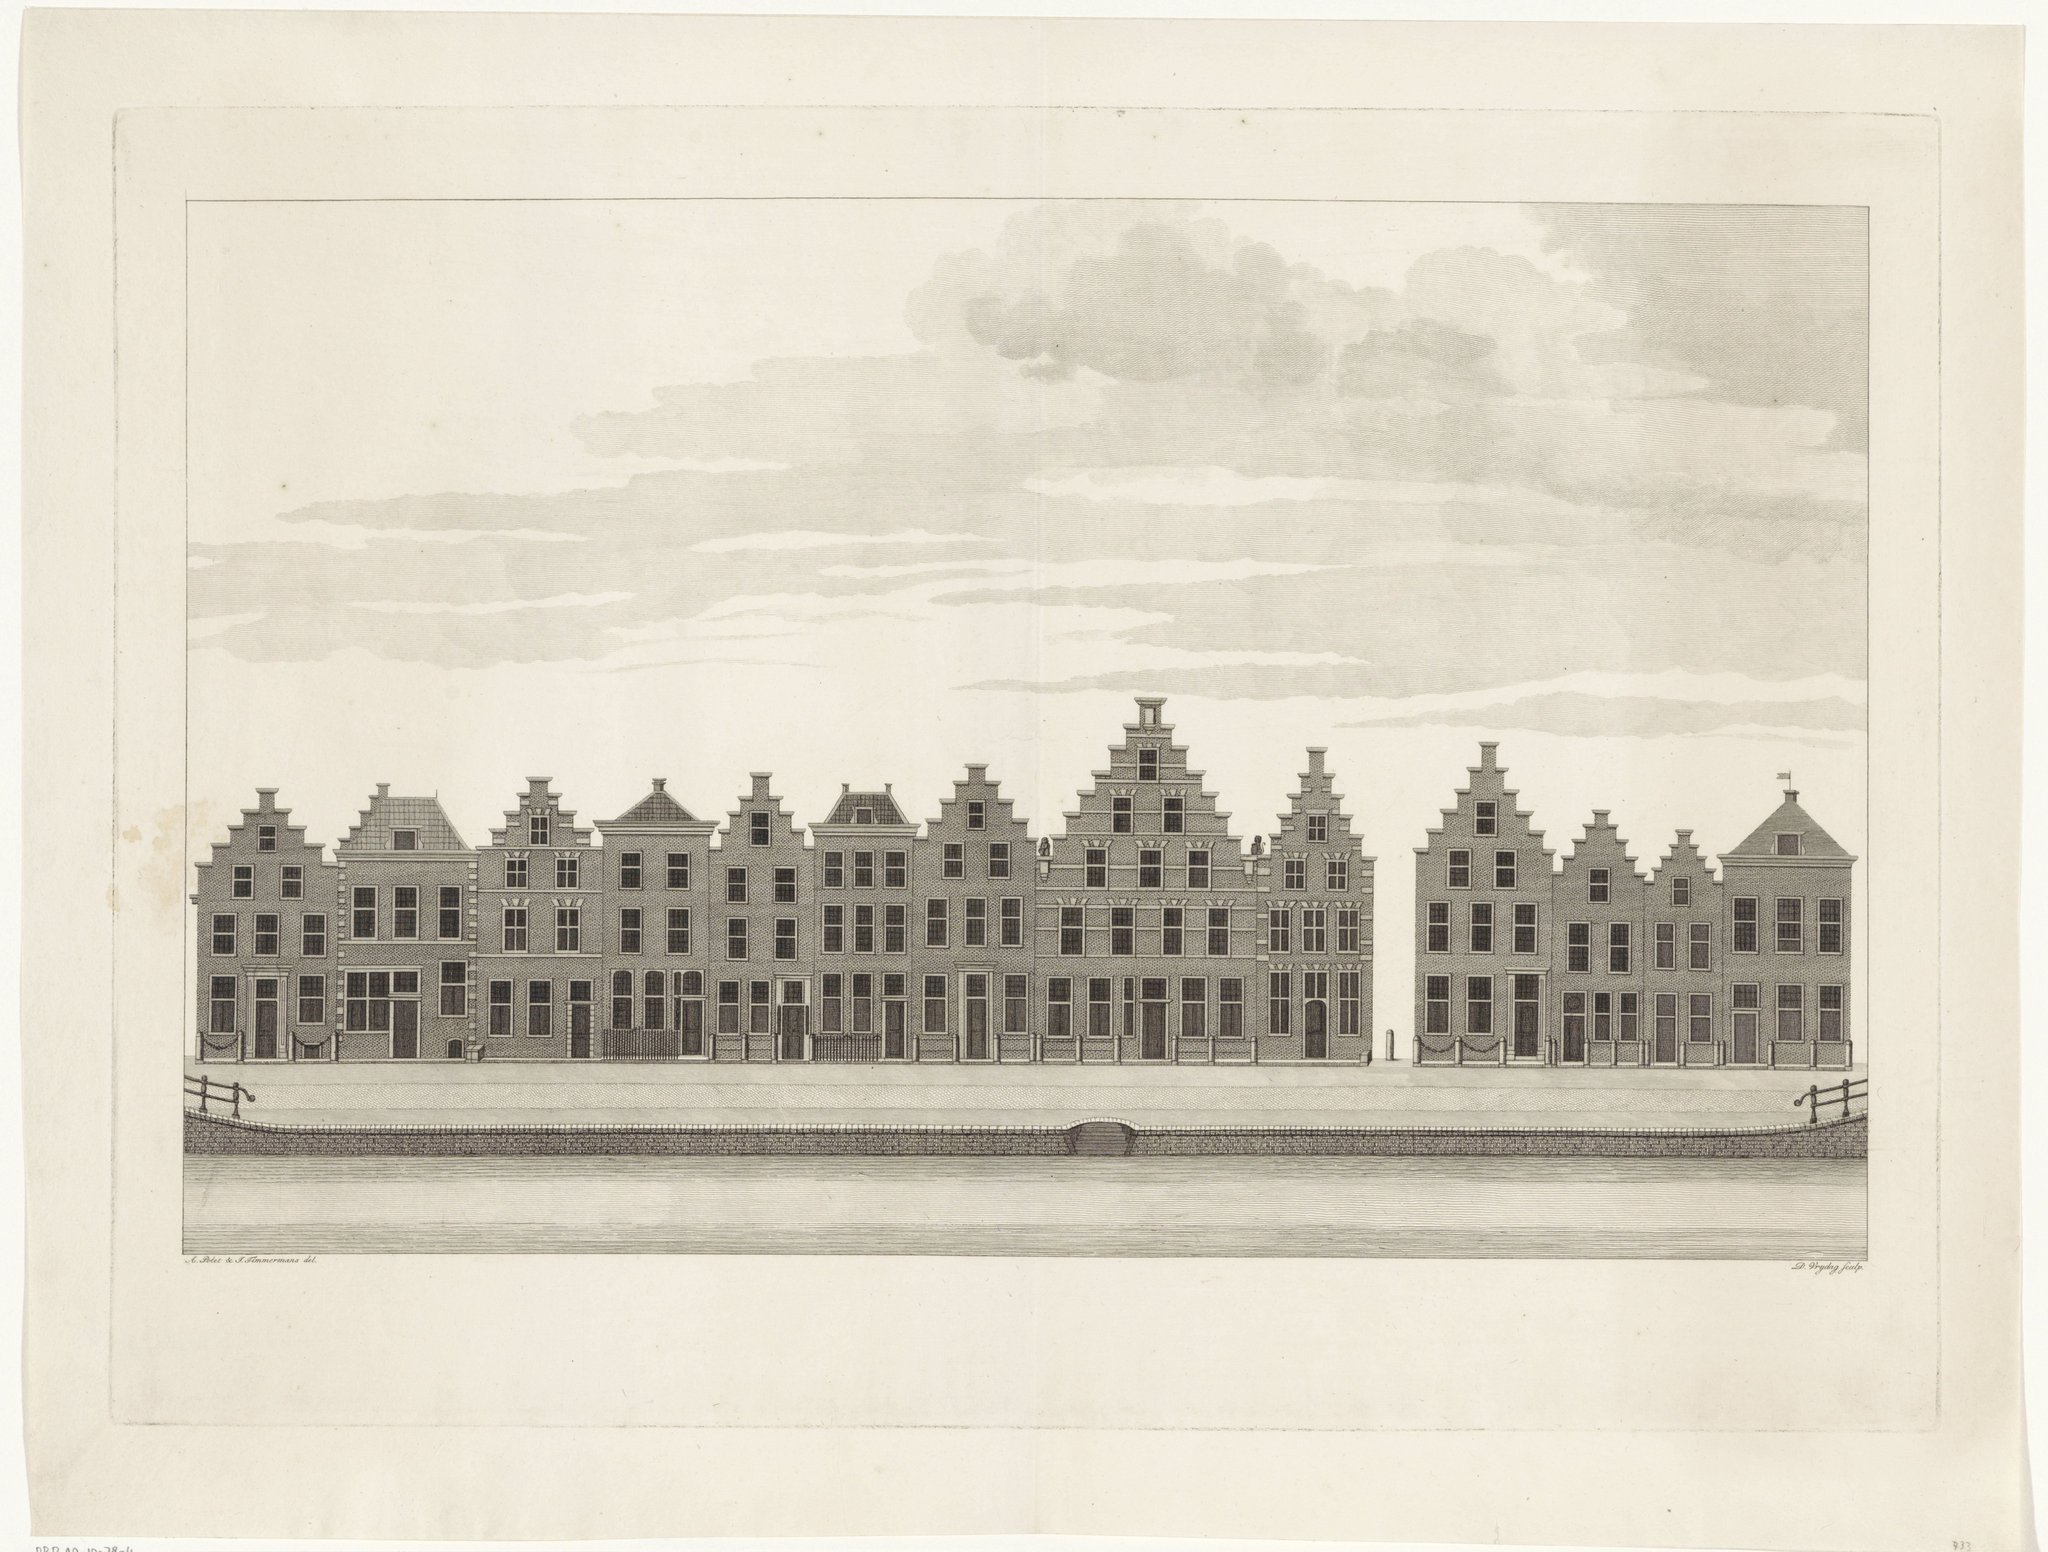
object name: history print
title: Gezicht op de huizen aan het Rapenburg te Leiden, van de Groenmarkt (of Garenmarkt) tot de Sint Jacobsgracht, voorafgaand aan de ramp van Leiden, 1807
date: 1807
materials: paper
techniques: engraving, etching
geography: amsterdam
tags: façade (of house or building), leiden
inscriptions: collector's mark: Lugt 2228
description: Gezicht op de gevels van de huizen aan het Rapenburg te Leiden, van de Groenmarkt (of Garenmarkt) tot de Sint Jacobsgracht. Situatie voor de ontploffing van het kruitschip op 12 januari 1807. Met een lege marge.